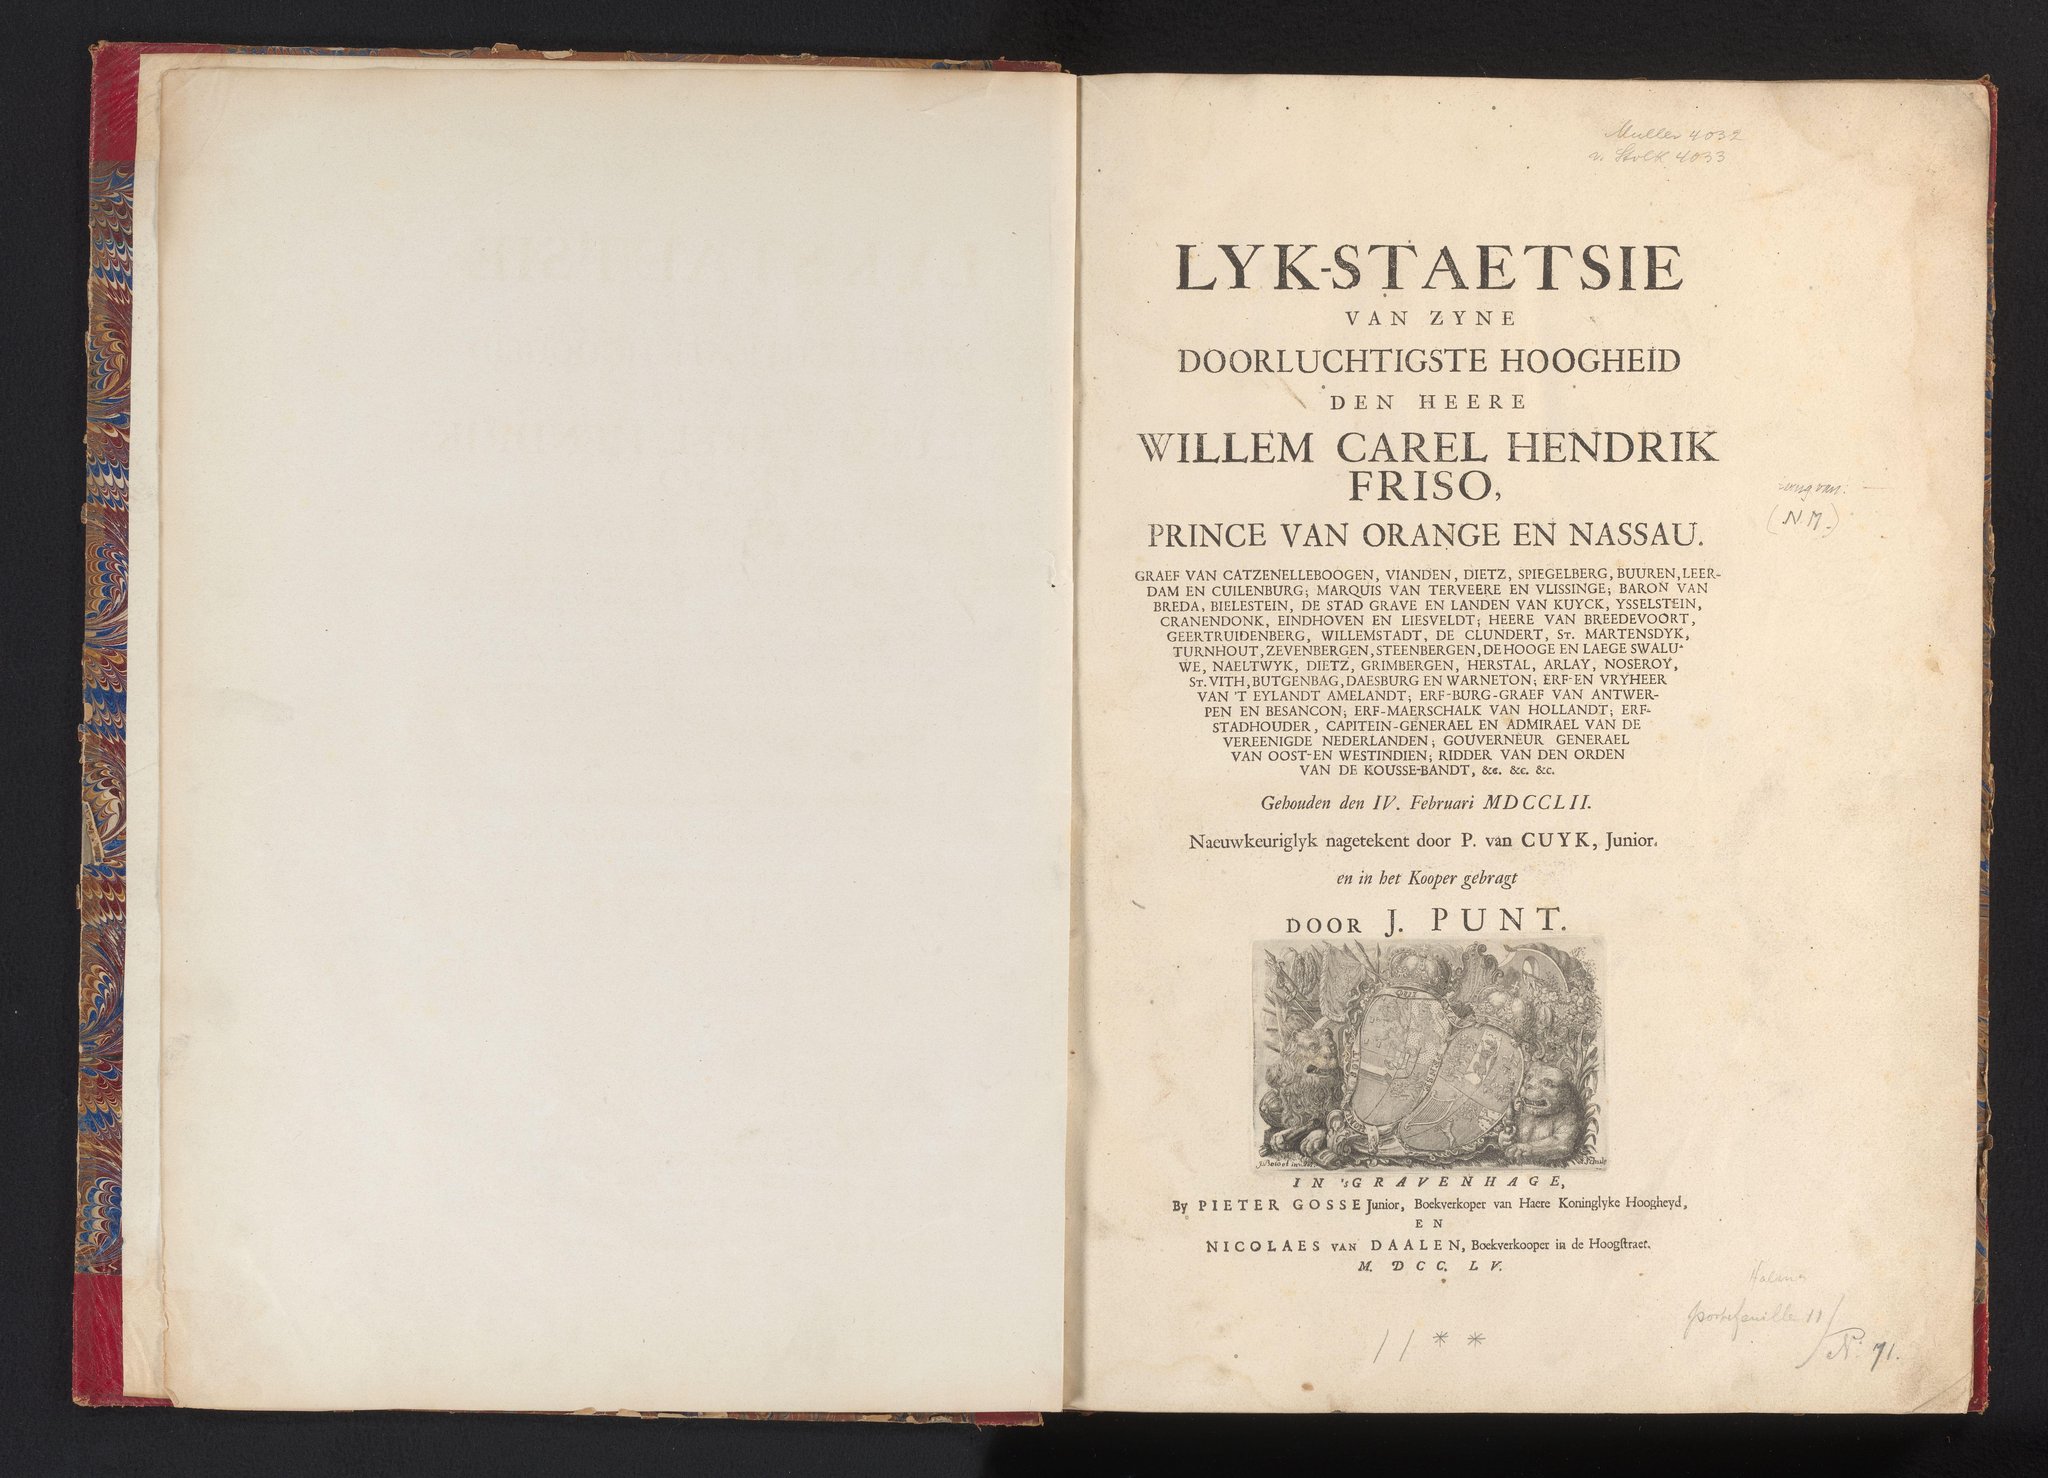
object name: titelblad, titelpagina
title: Titelpagina voor: Lyk-staetsie van zyne doorluchtigste Hoogheid den Heere Willem Carel Hendrik Friso, 1755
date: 1755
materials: paper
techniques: engraving, etching, letterpress printing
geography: the hague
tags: the hague, willem iv (prins van oranje-nassau), anna van hannover, coat of arms (symbol of sovereignty), armorial bearing, heraldry, delft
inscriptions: collector's mark: ‘RIJKS / MUSM’, collector's mark: ‘B’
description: Titelpagina voor de gebonden uitgave van de serie van 41 platen van de begrafenisstoet van stadhouder Willem IV te Delft op 4 februari 1752. Onder de titel een voorstelling met de wapens van de prins en prinses van Oranje, met twee leeuwen en vaandels. De prent maakt deel uit van een album.